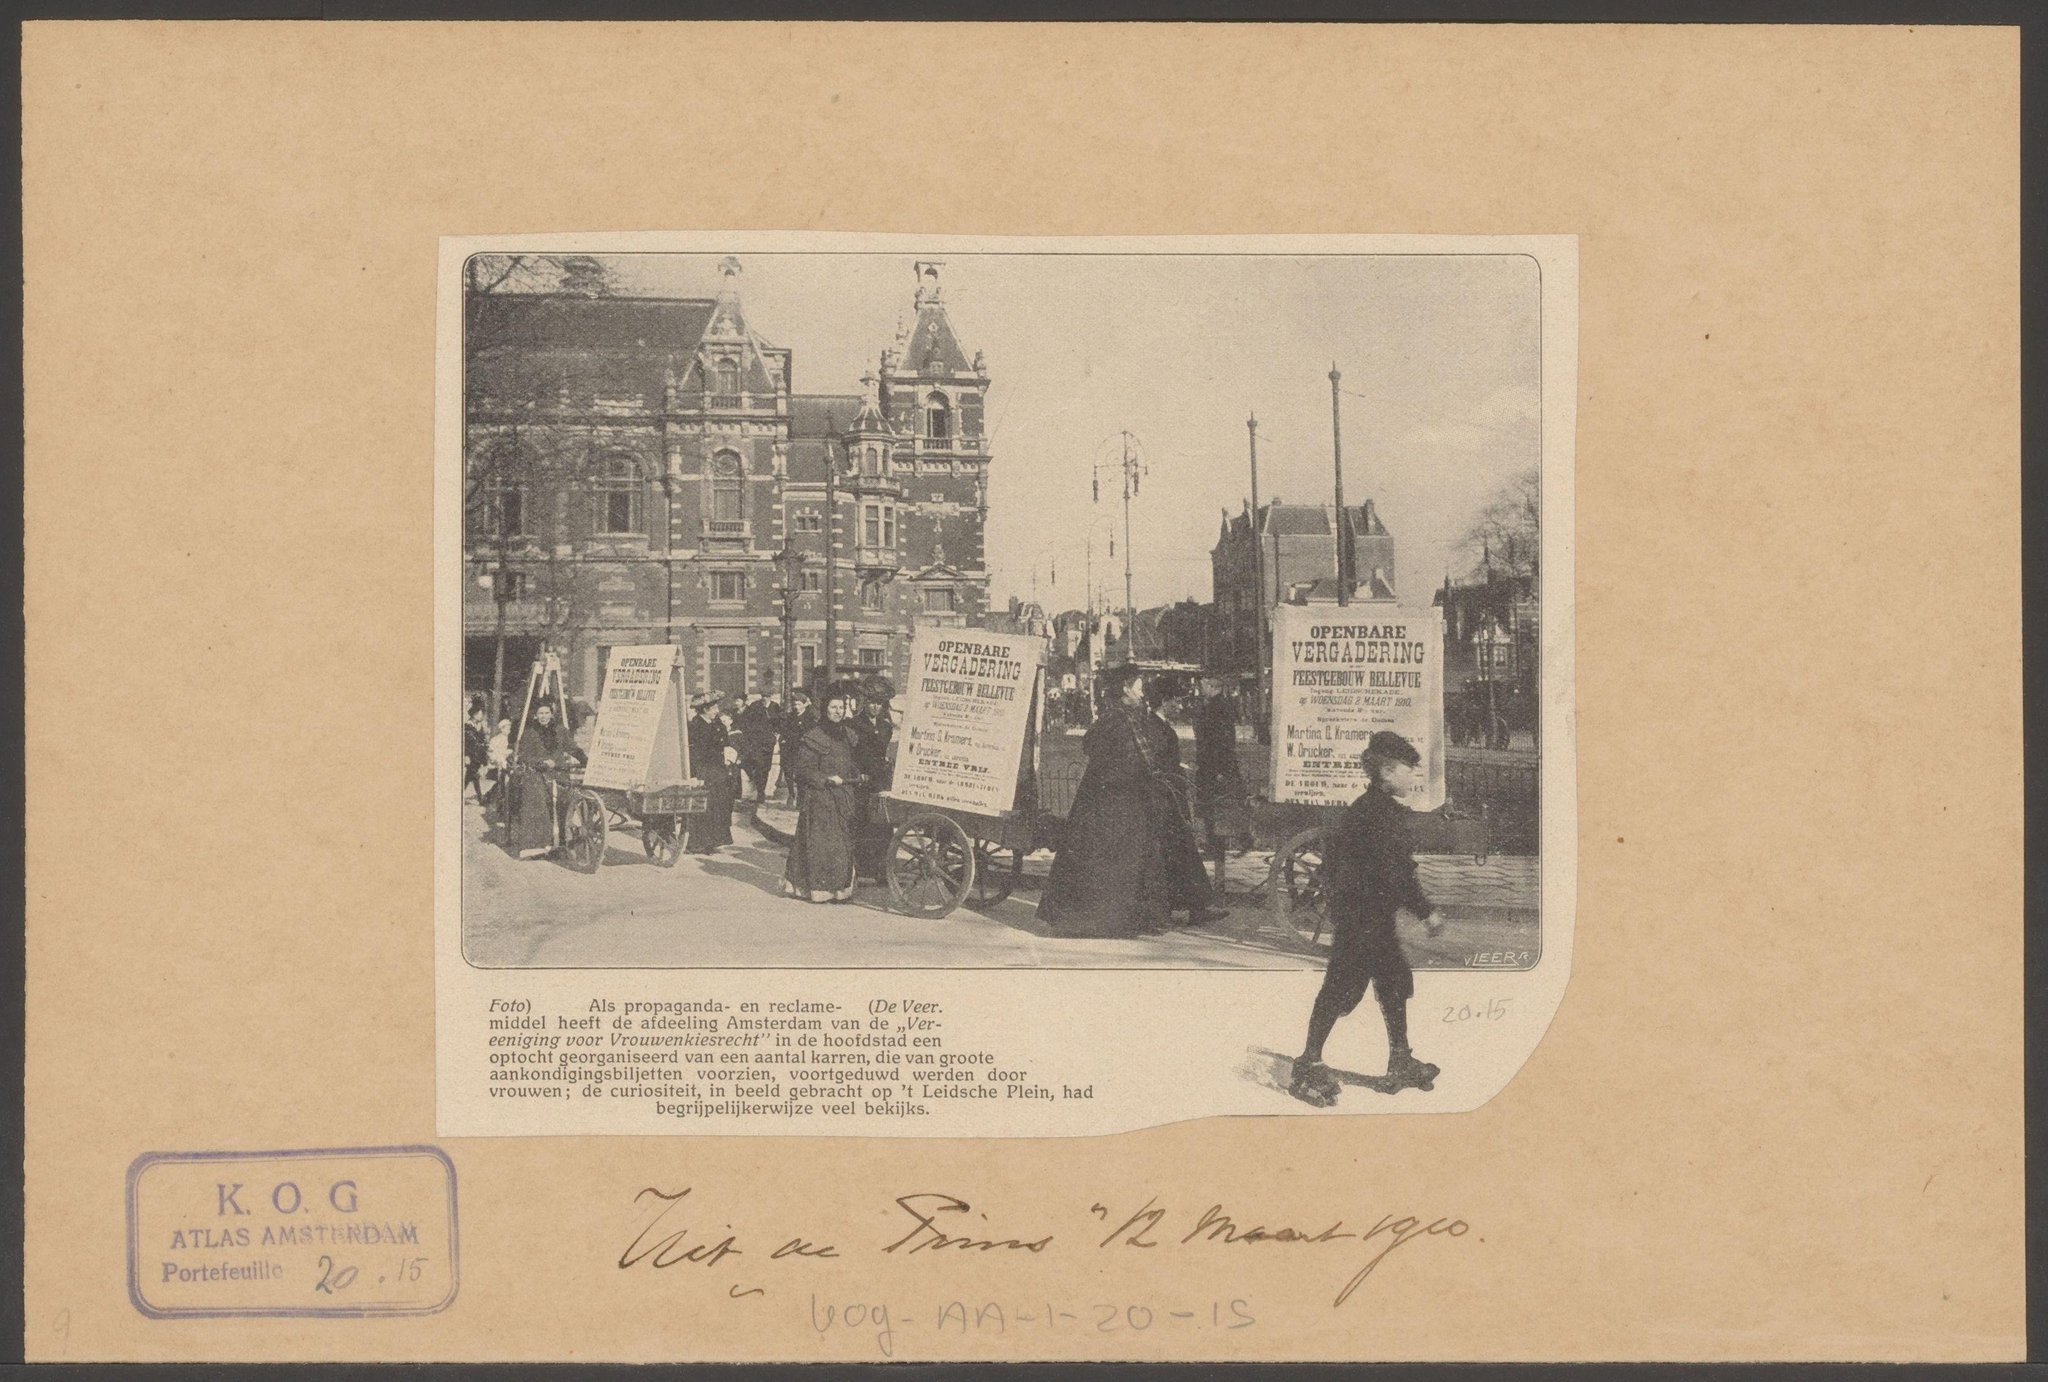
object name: photomechanical print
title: Optocht van de Vereeniging voor Vrouwenkiesrecht te Amsterdam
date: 1910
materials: paper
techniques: letterpress printing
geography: amsterdam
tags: political demonstration, political enfranchisement of women, women's liberation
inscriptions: collector's mark: Lugt 1641b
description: Onderwerpsrubriek binnen de Atlas Amsterdam: Kaarten kiesdistricten.